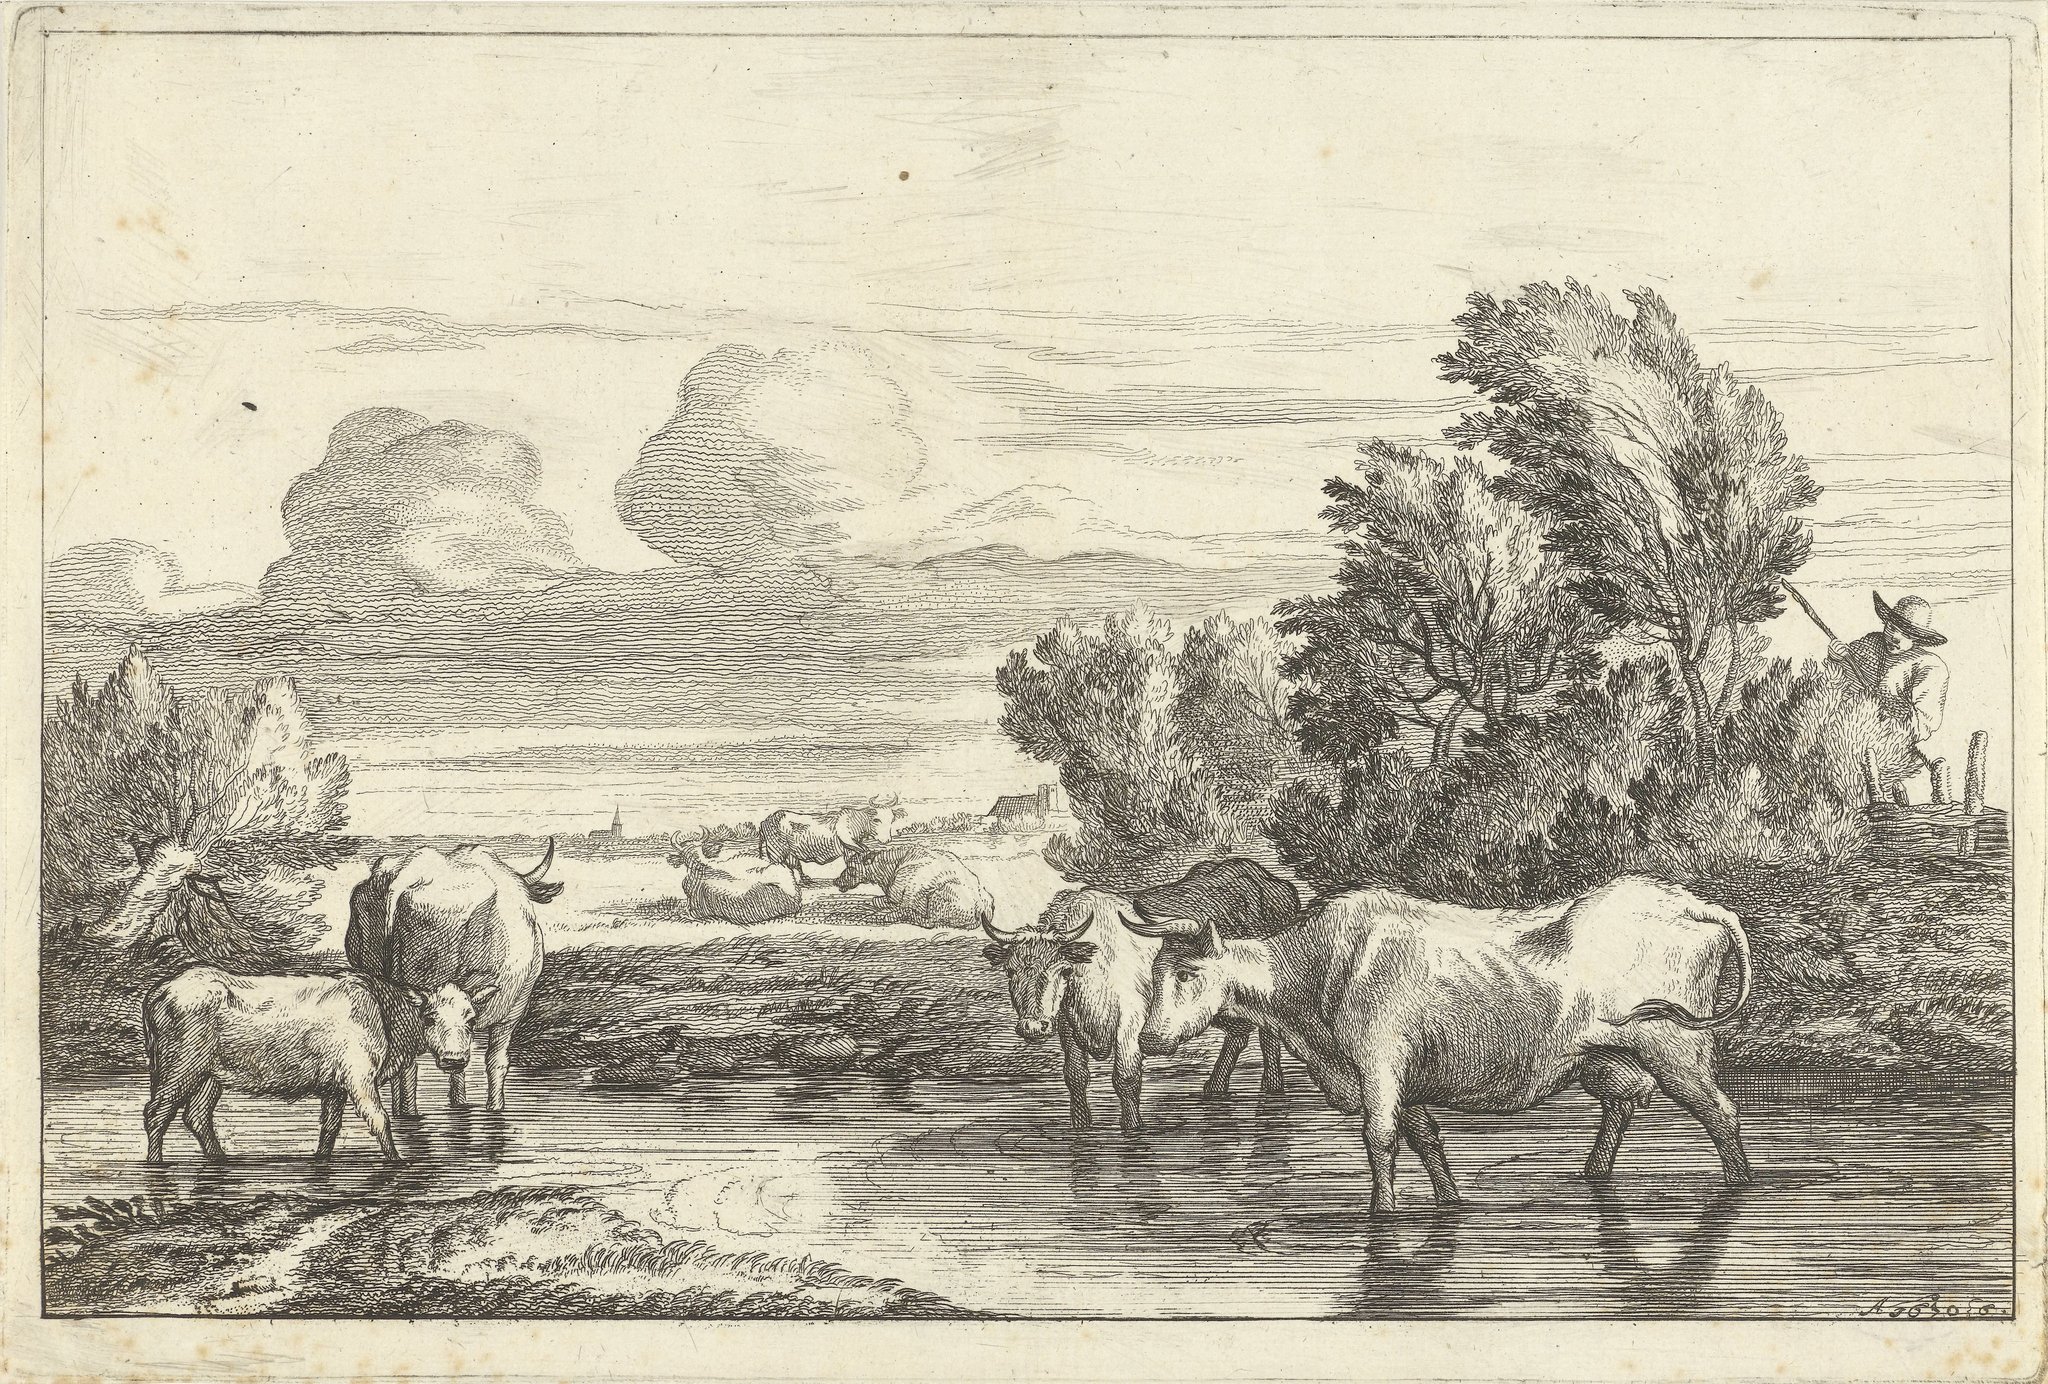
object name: print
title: Landschap met koeien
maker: johannes gronsveld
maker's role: draughtsman, painter, print maker, publisher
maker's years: 1658-1728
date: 1670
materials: paper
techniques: engraving, etching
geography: amsterdam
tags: cow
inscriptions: collector's mark: Lugt 240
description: Landschap met vier koeien in een rivier en drie in de wei. Op de wal staat een herder gedeeltelijk verscholen achter een struik. Op de achtergrond een kerk.